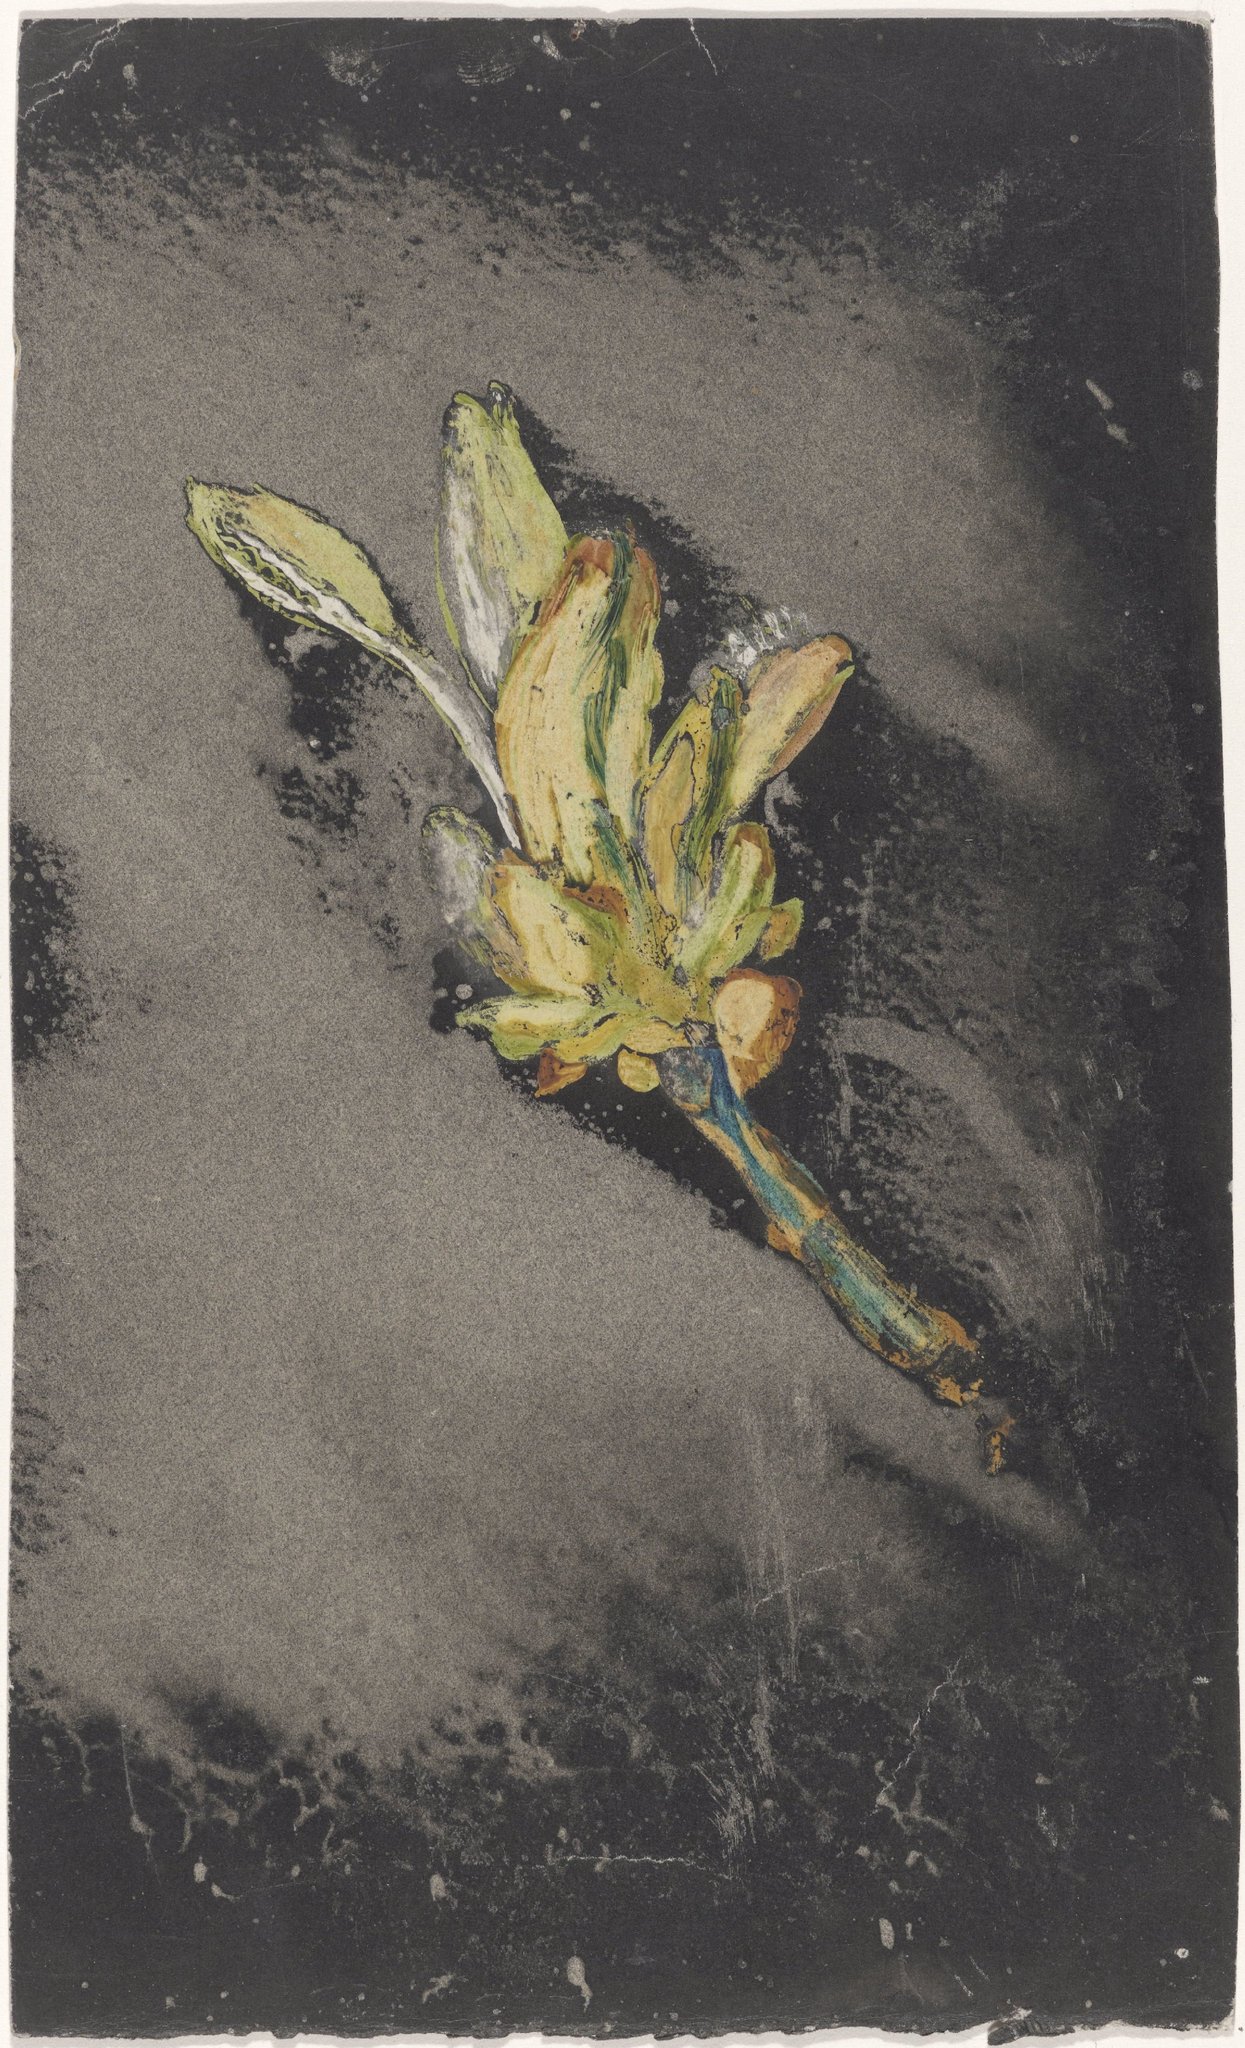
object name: drawing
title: Bloem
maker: carel adolph lion cachet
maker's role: draughtsman, print maker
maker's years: 1864-1945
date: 1874-1945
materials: cardboard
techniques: brush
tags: flowers